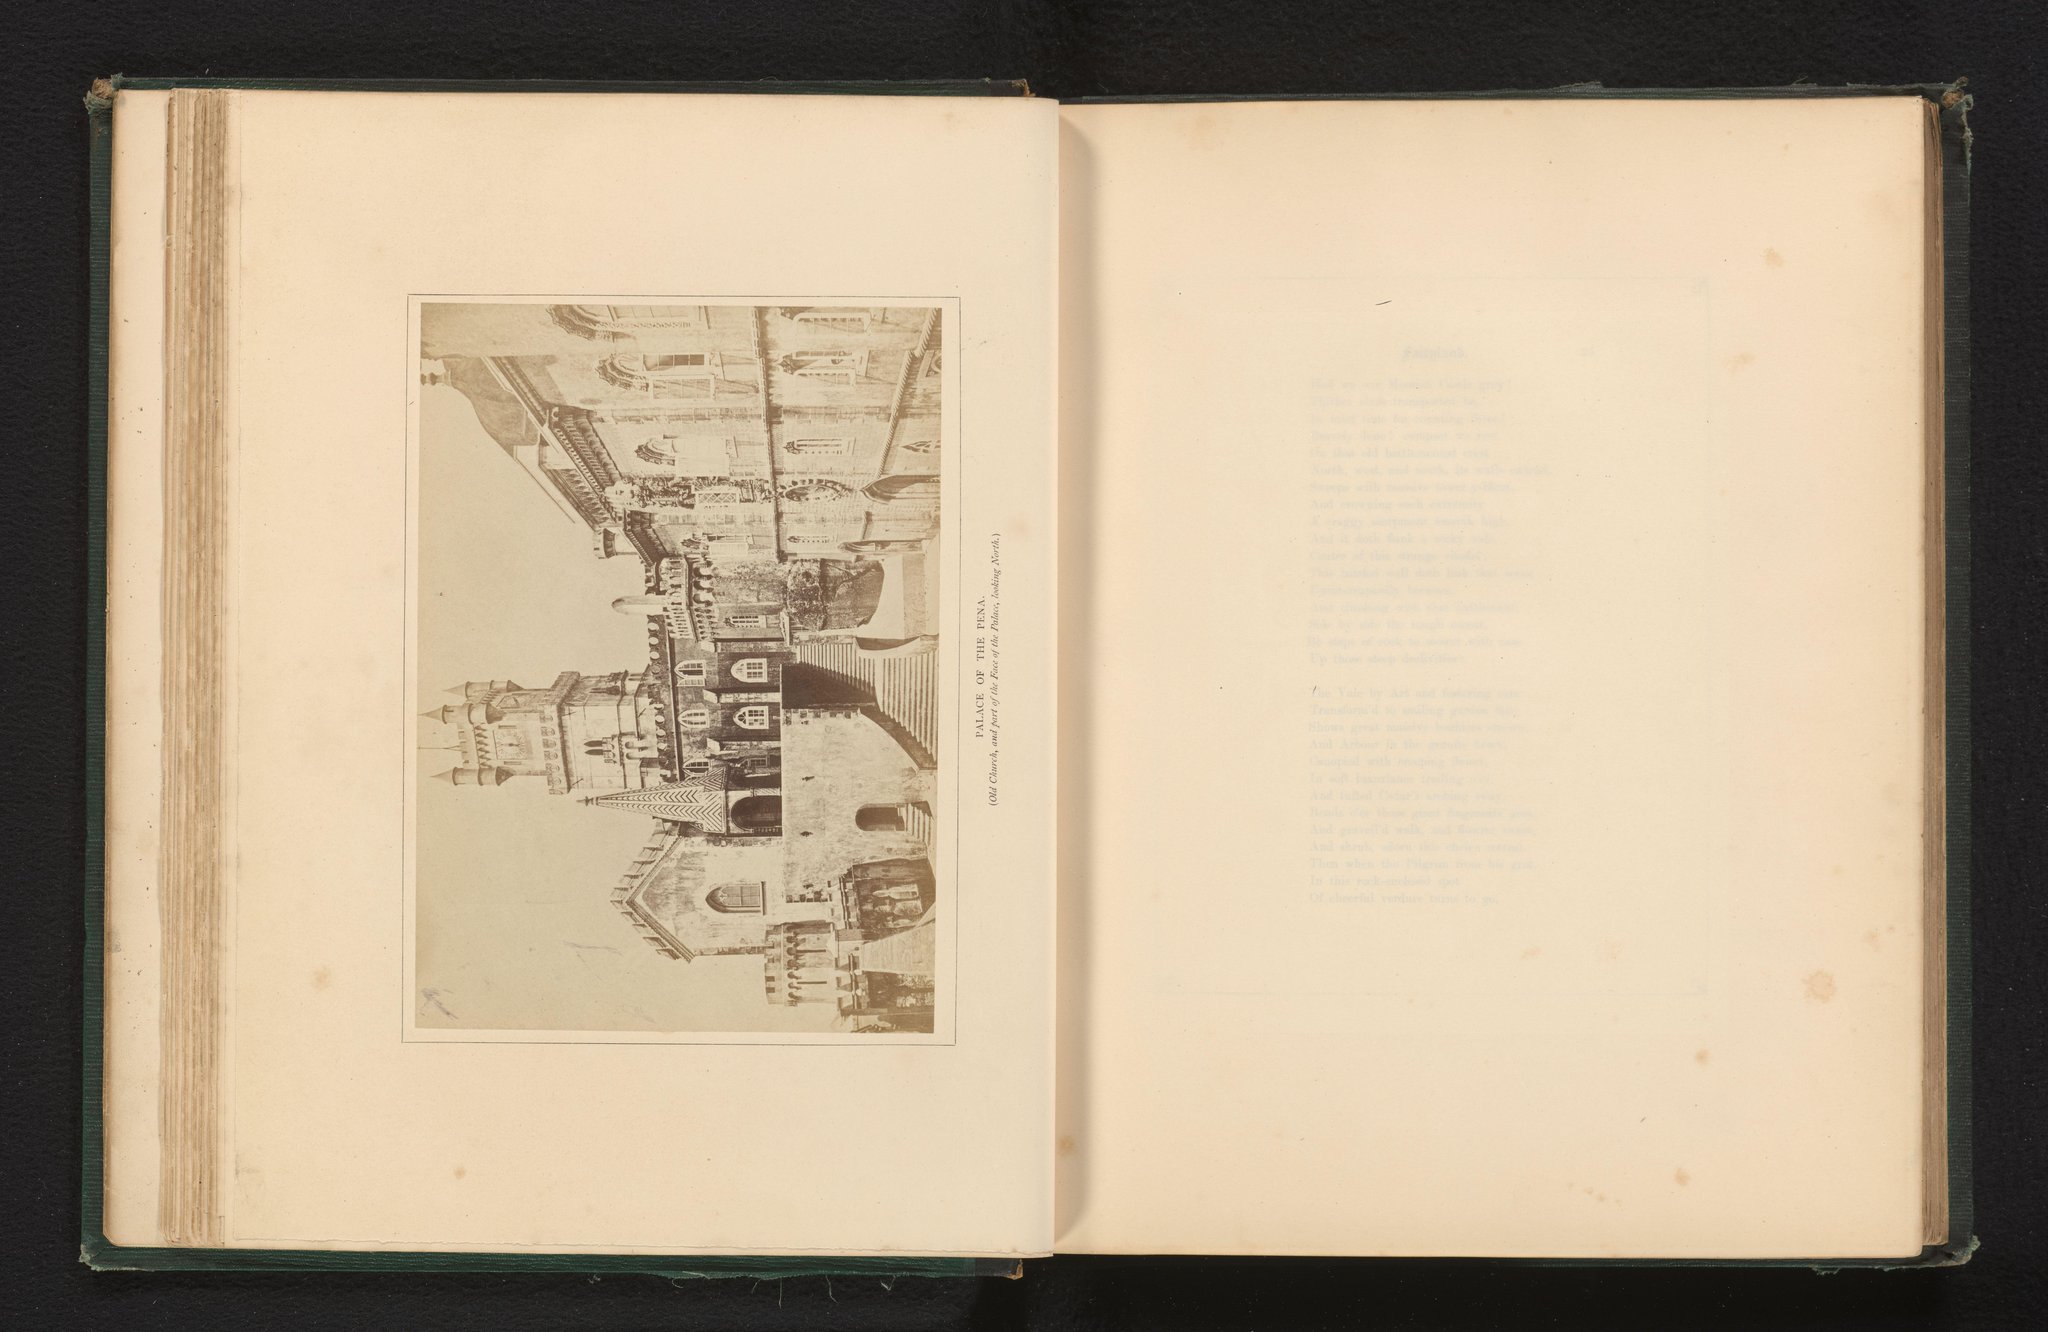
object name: photograph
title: Palace of the Pena (Old church, and part of the Face of the Palace, looking north)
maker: Anonymous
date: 1865-1870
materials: paper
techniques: albumen print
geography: sintra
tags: palace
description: Foto op tweede ongenummerde pagina na pagina 24.